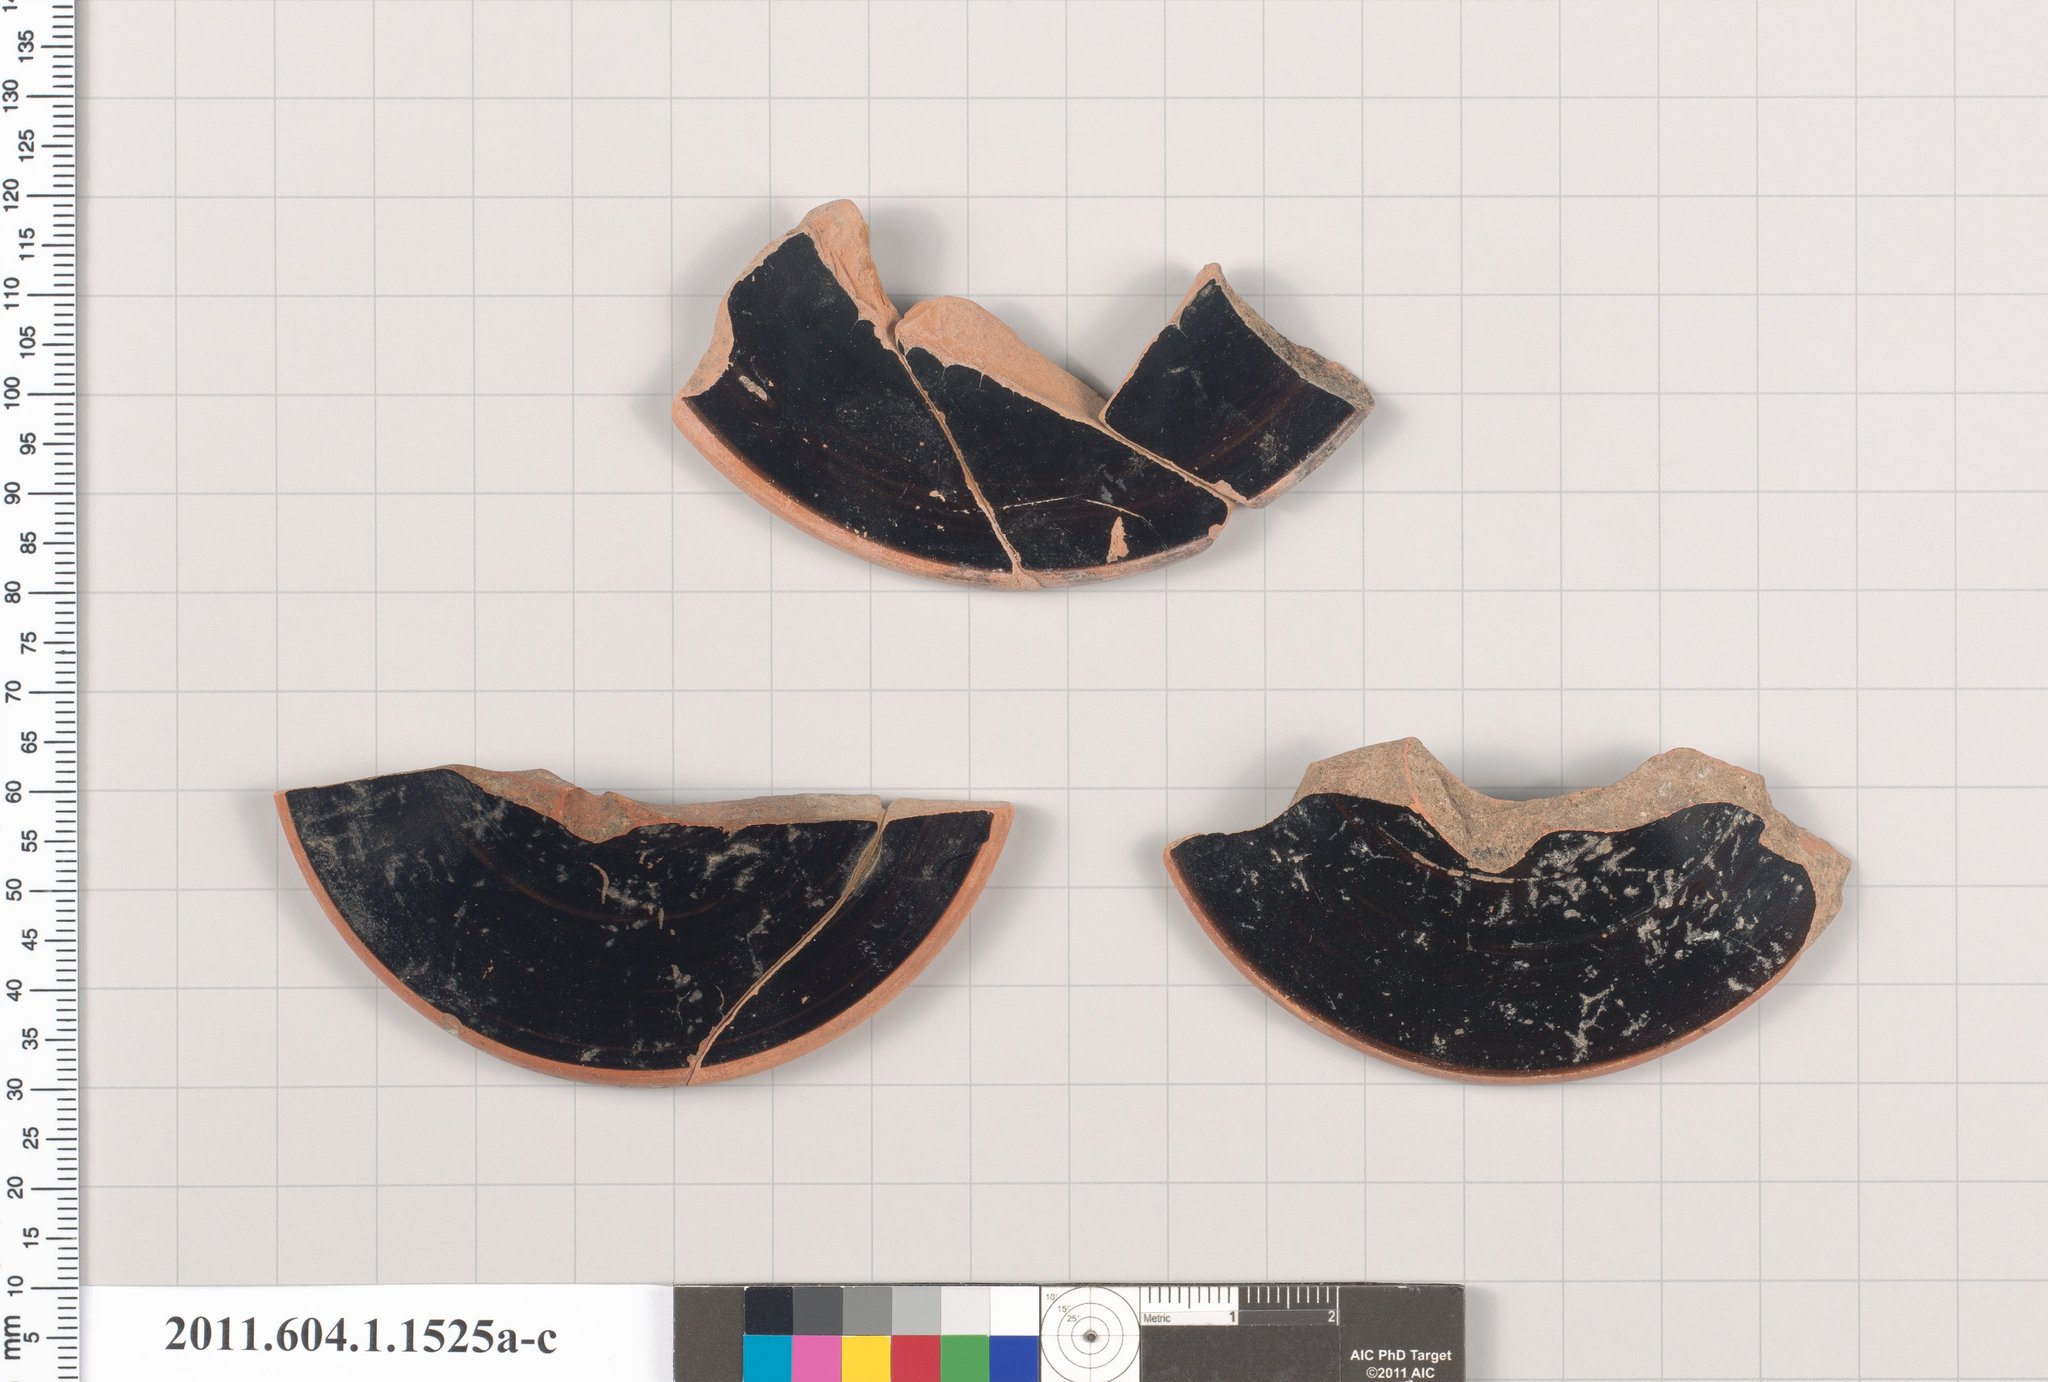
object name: kylix fragment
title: Terracotta fragments of kylikes (drinking cups)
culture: greek, attic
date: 500-401 BCE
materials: terracotta